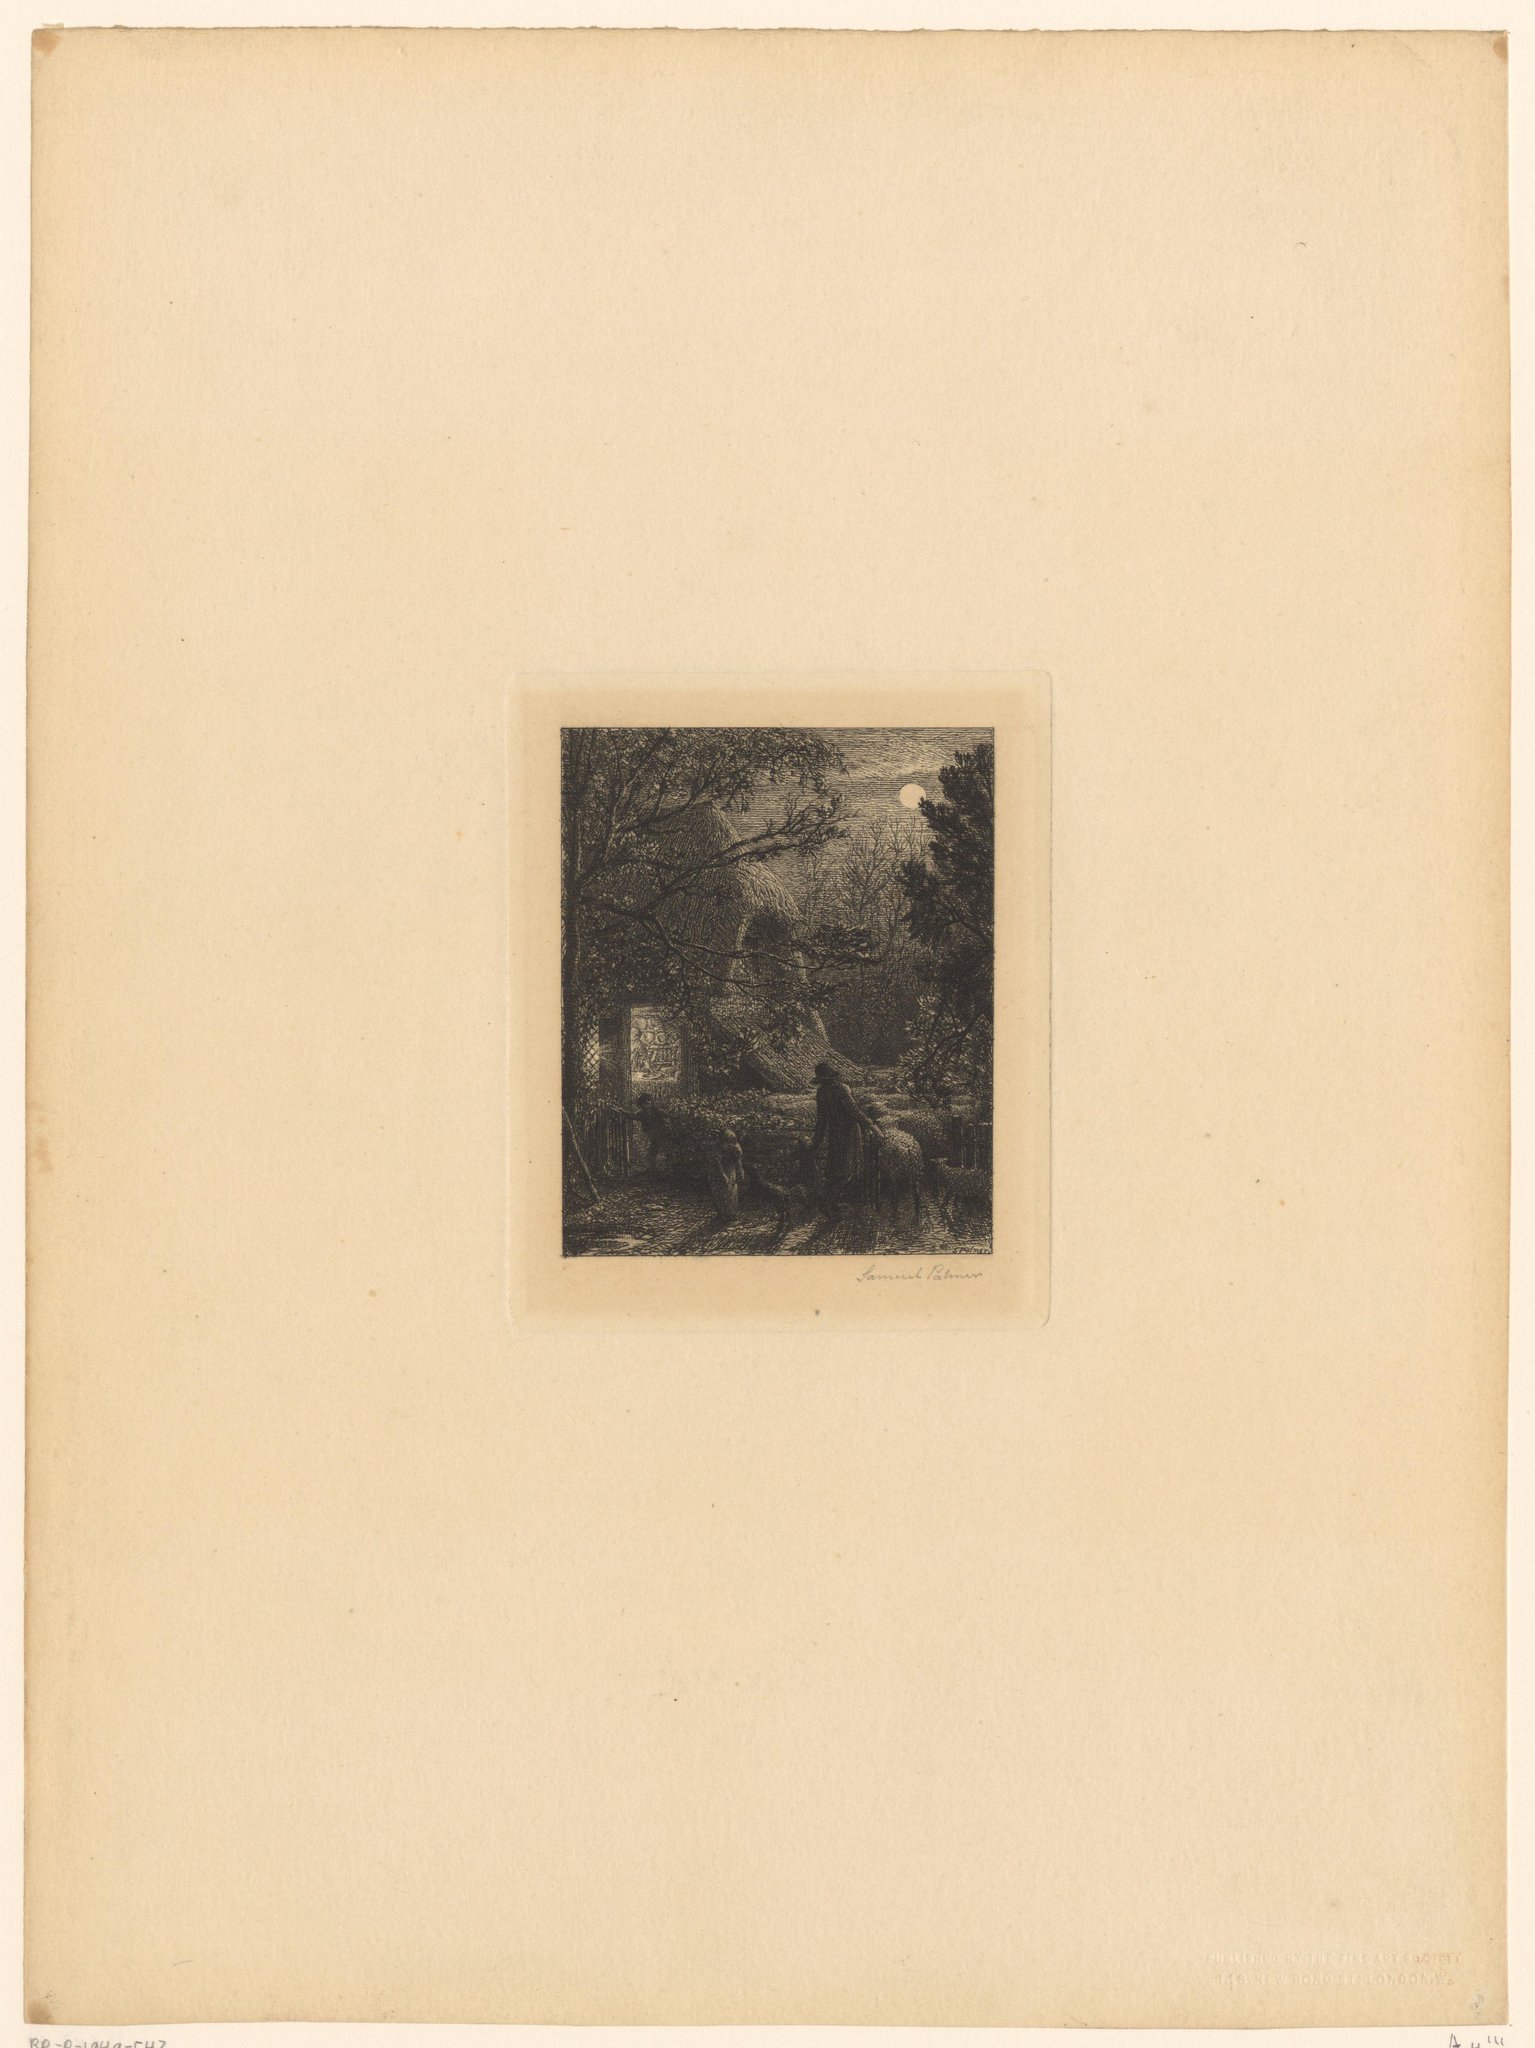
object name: print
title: Folding the last sheep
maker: samuel palmer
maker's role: draughtsman, painter, print maker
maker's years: 1805-1881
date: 1850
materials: paper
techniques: etching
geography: england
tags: moonlight, sheep, cottage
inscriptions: collector's mark: Lugt 2228, signature: ‘Samuel Palmer’